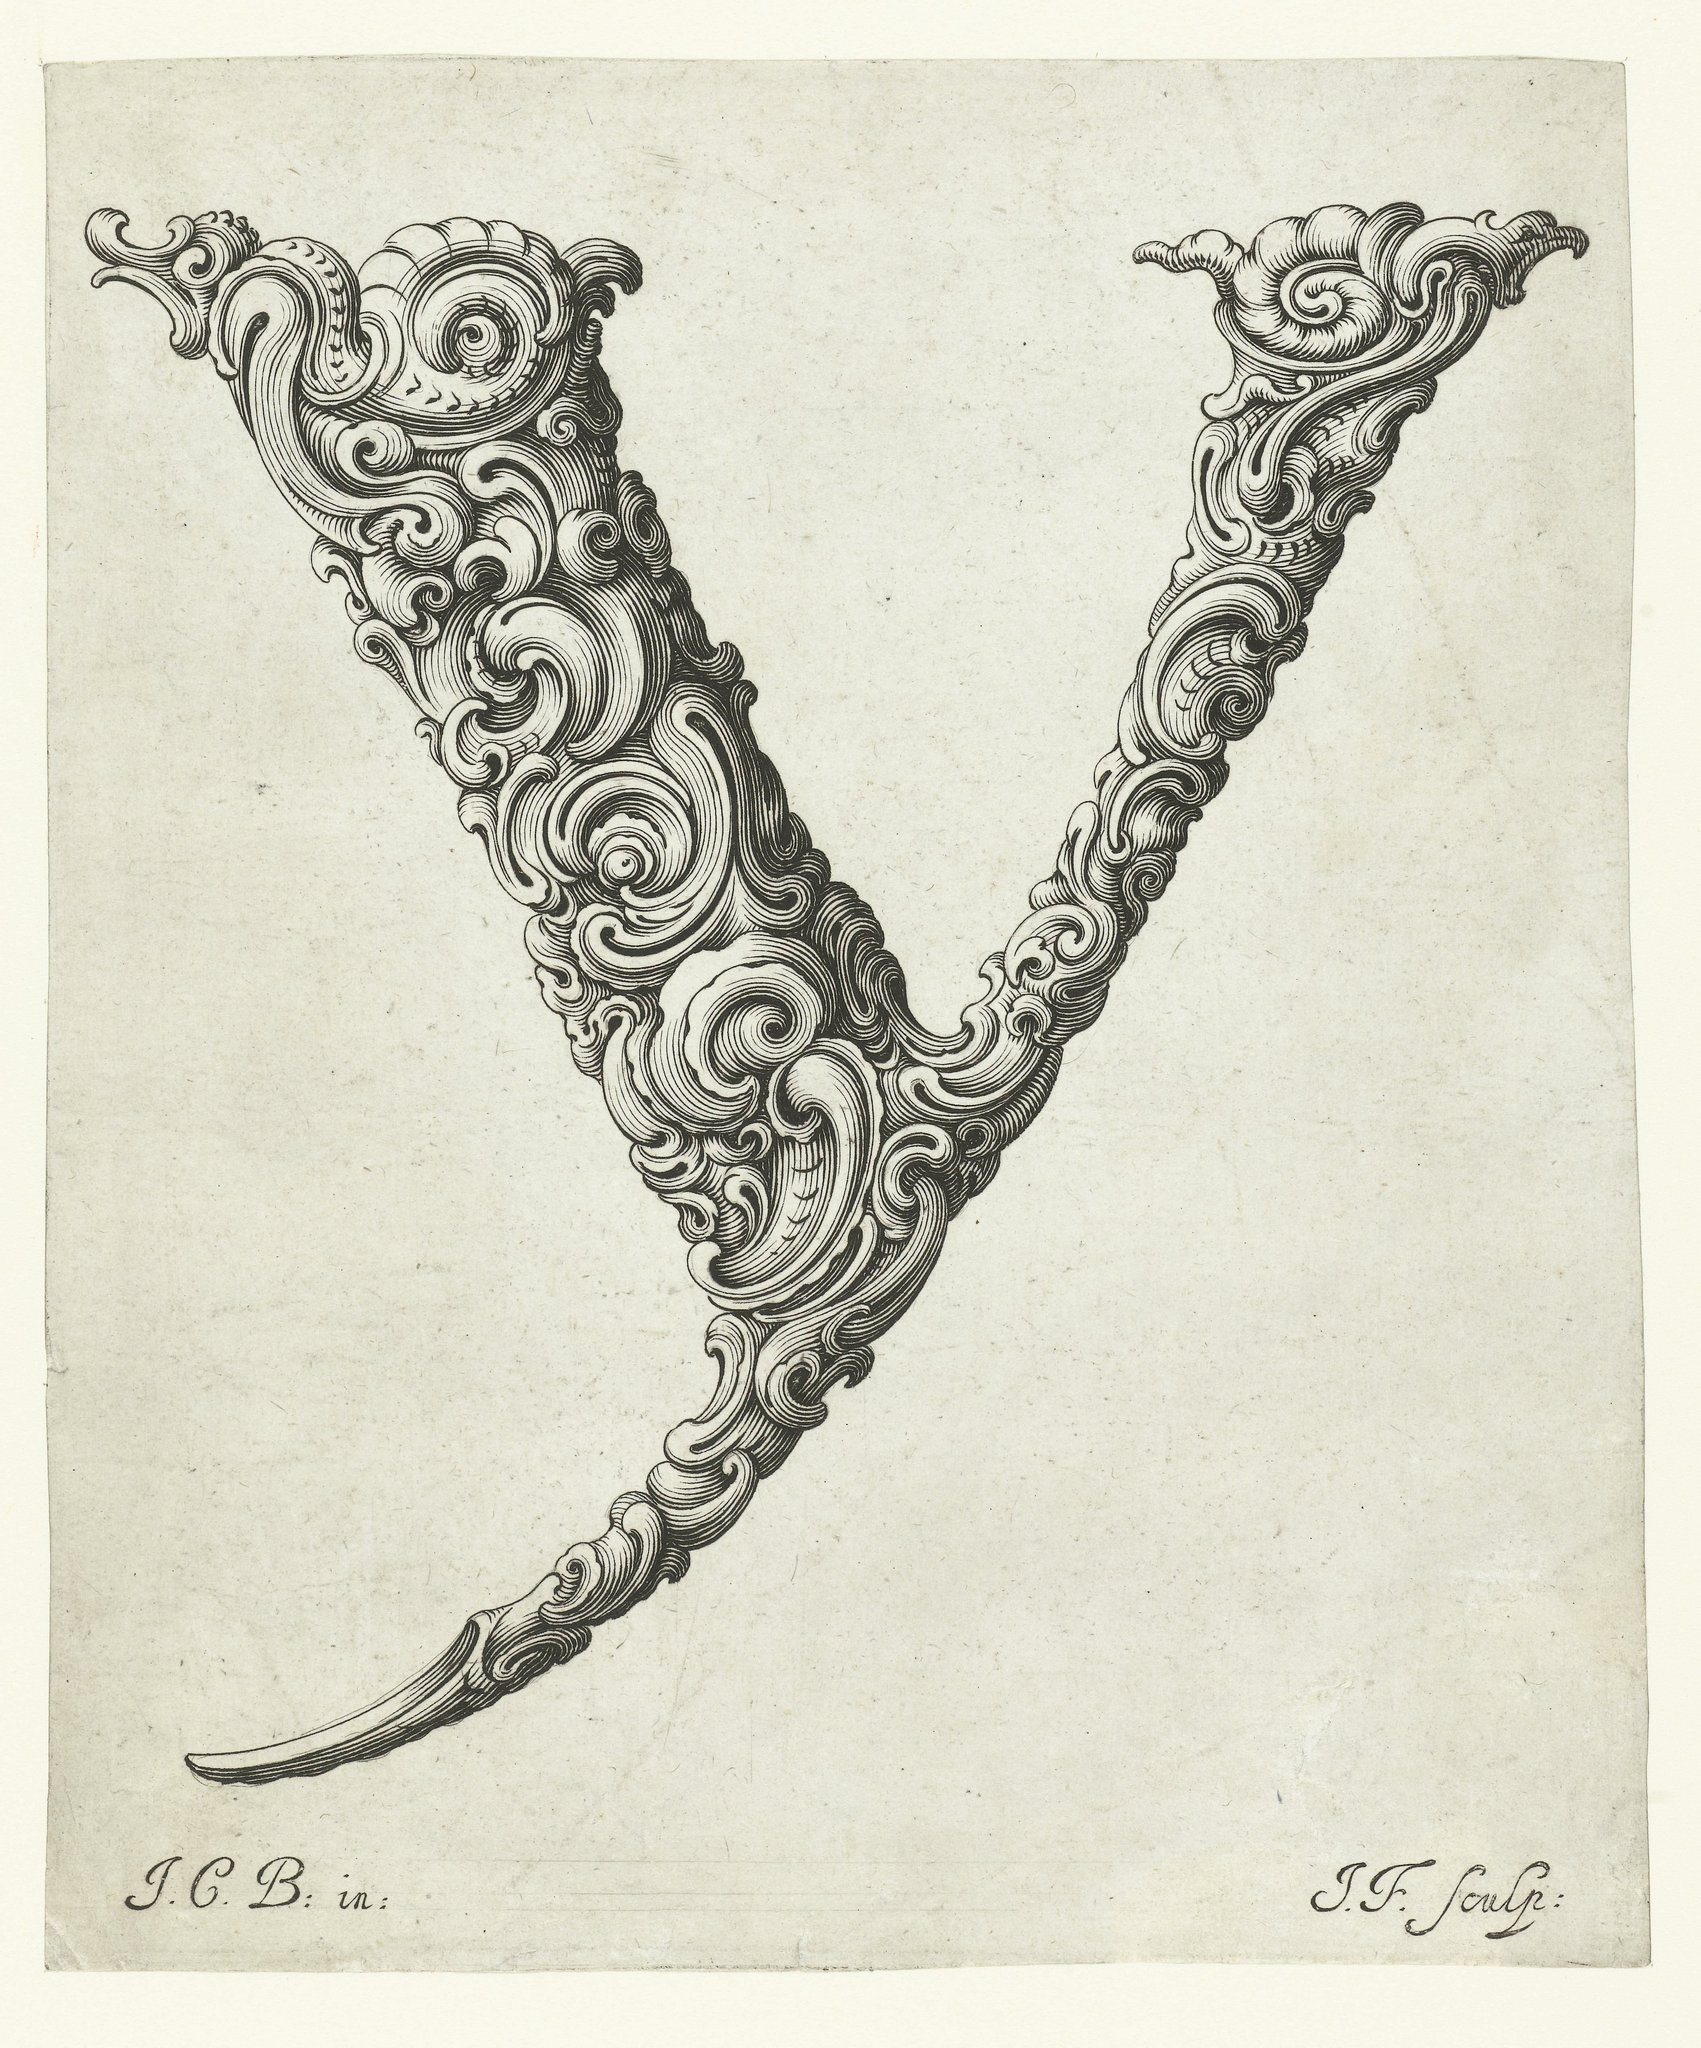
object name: ornament print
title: Letter Y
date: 1645-1650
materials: paper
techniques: engraving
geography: hamburg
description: Blad met de letter Y uit serie van 26 bladen met letters uit het alfabet.